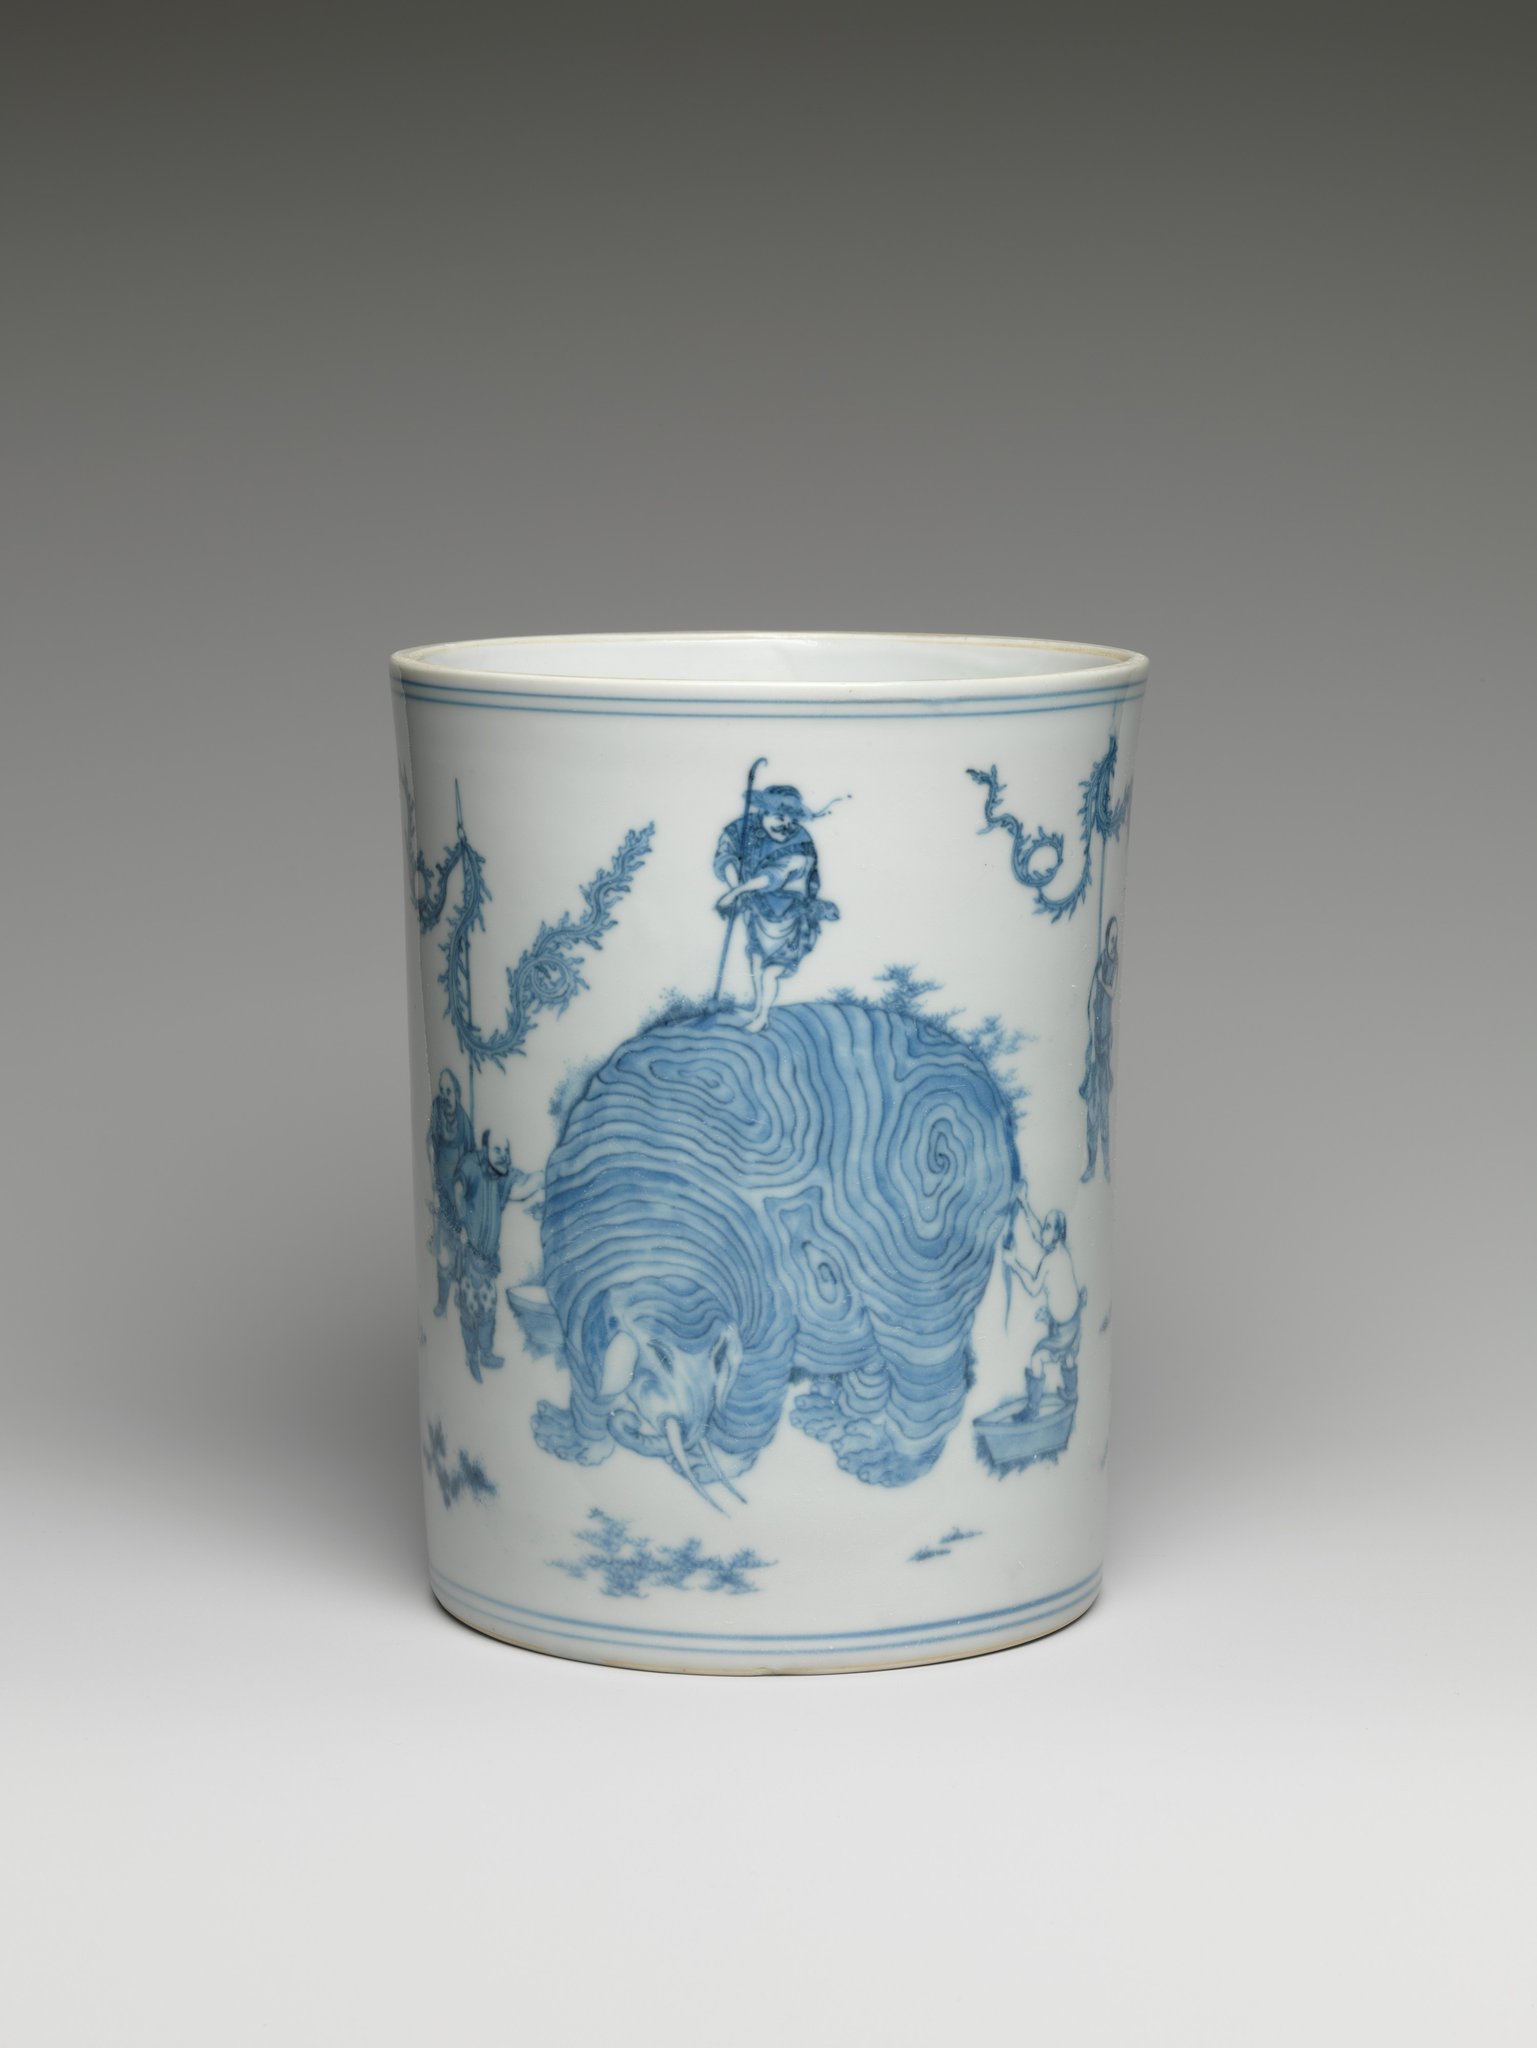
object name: brush pot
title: Brush Pot with Scene of Washing an Elephant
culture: chinese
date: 1634-1666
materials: cobalt, glaze, porcelain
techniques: painting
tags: men,elephants